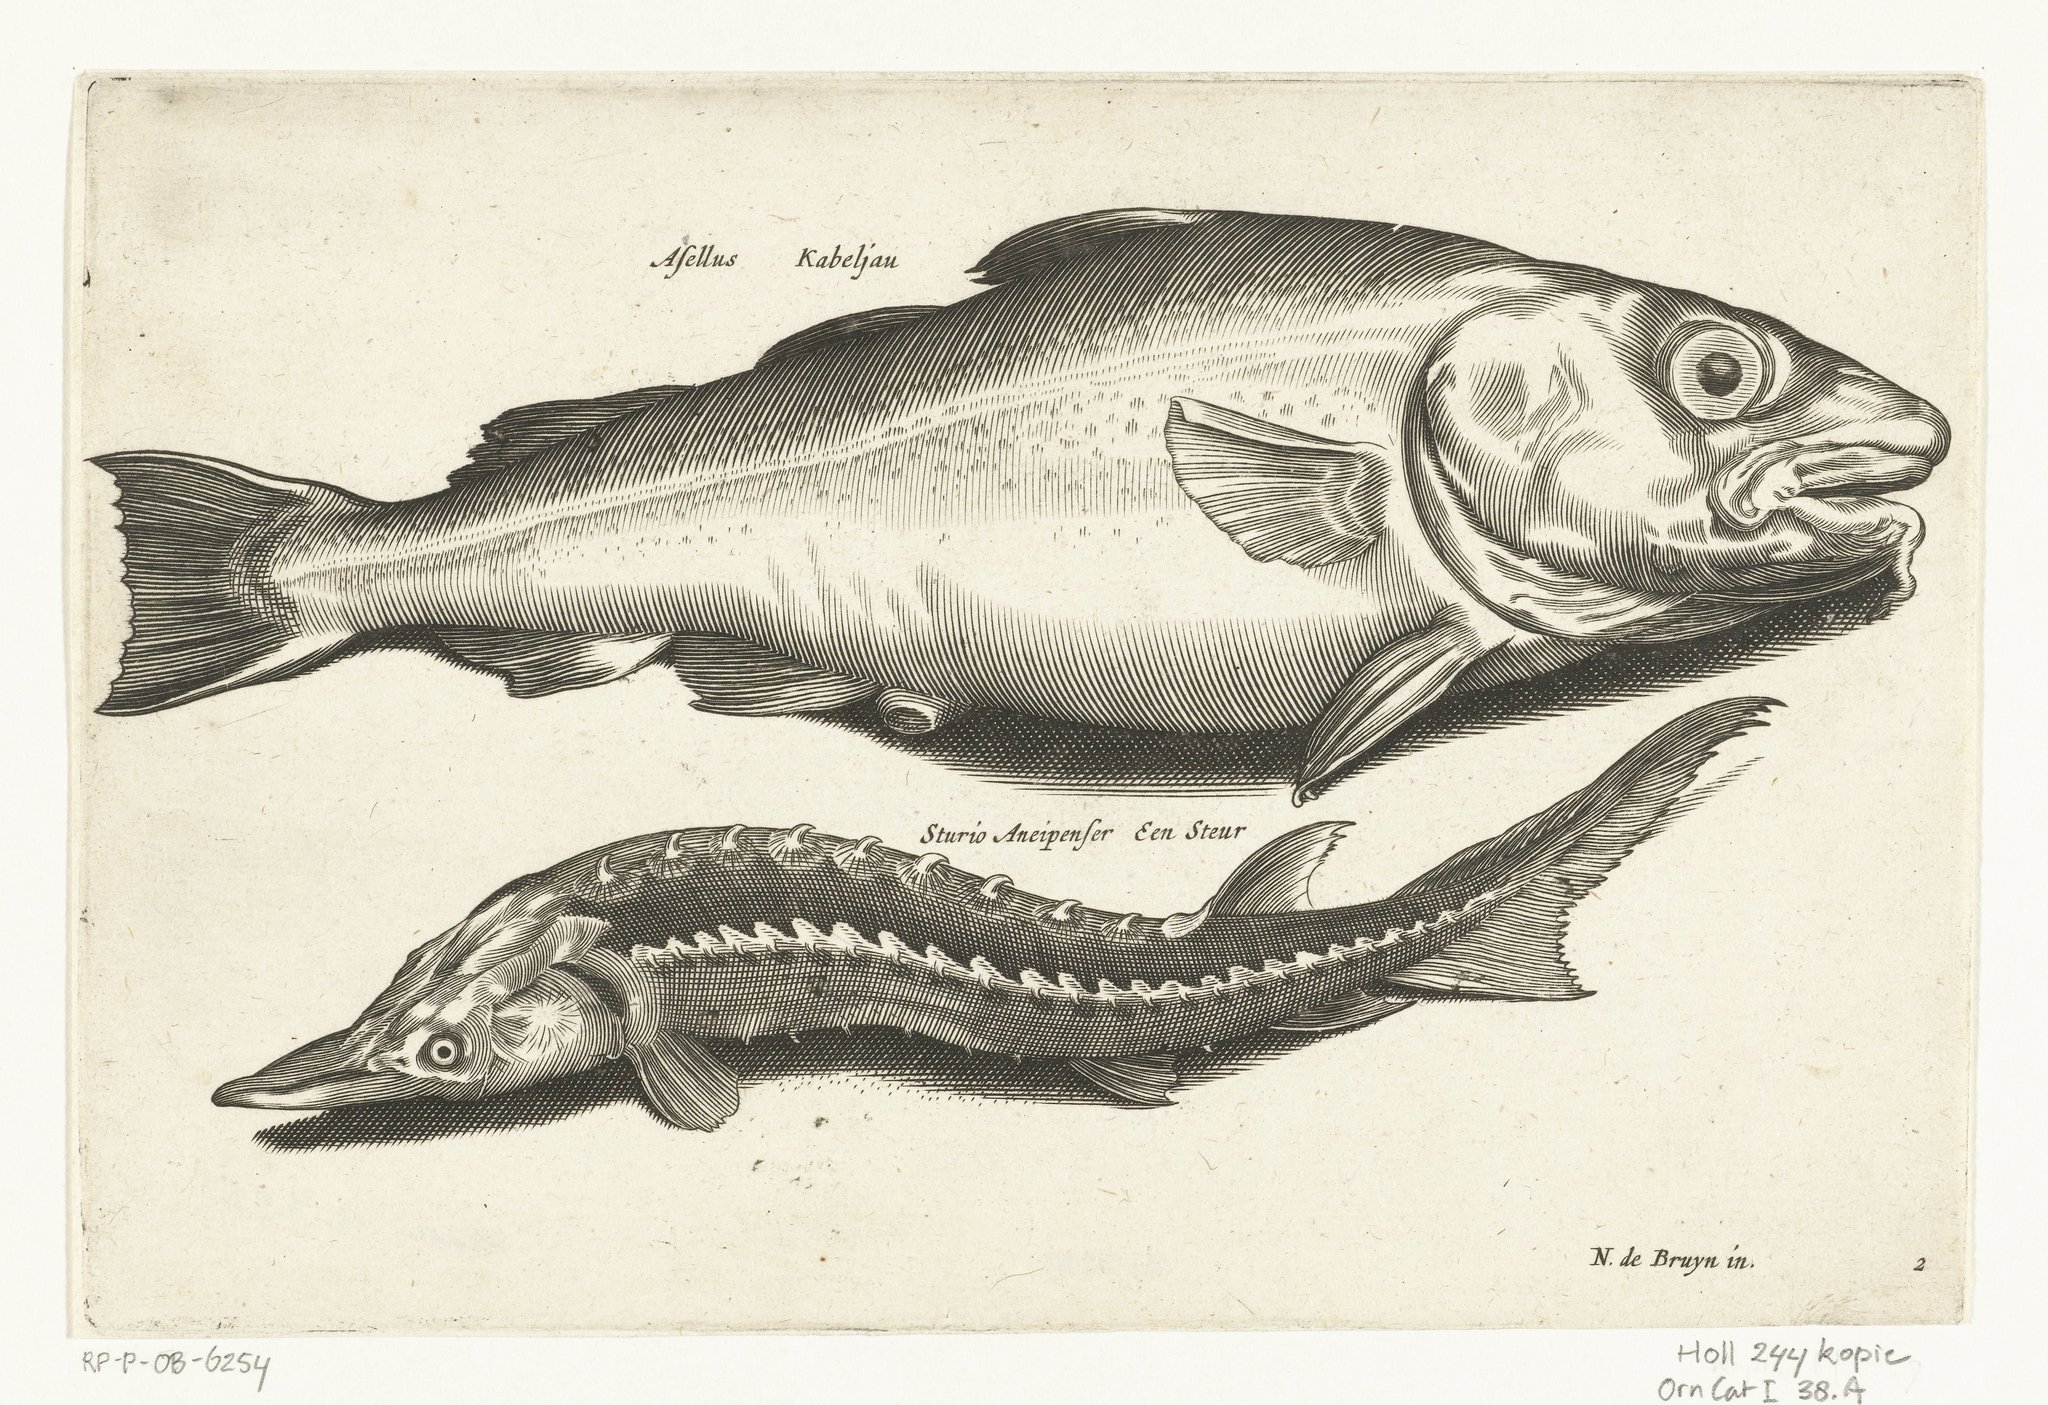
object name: print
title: Libelivs varia Genera piscium complectens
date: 1581-1652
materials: paper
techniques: engraving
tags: fishes, bony fishes: sturgeon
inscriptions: collector's mark: Lugt 2228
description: Kopie naar prent van Nicolaes de Bruyn. Prent uit serie Libelivs varia Genera piscium complectens van dertien prenten met zoetwatervissen, zeevissen, kikkers, schaaldieren en zeewezens (inclusief titelprent).